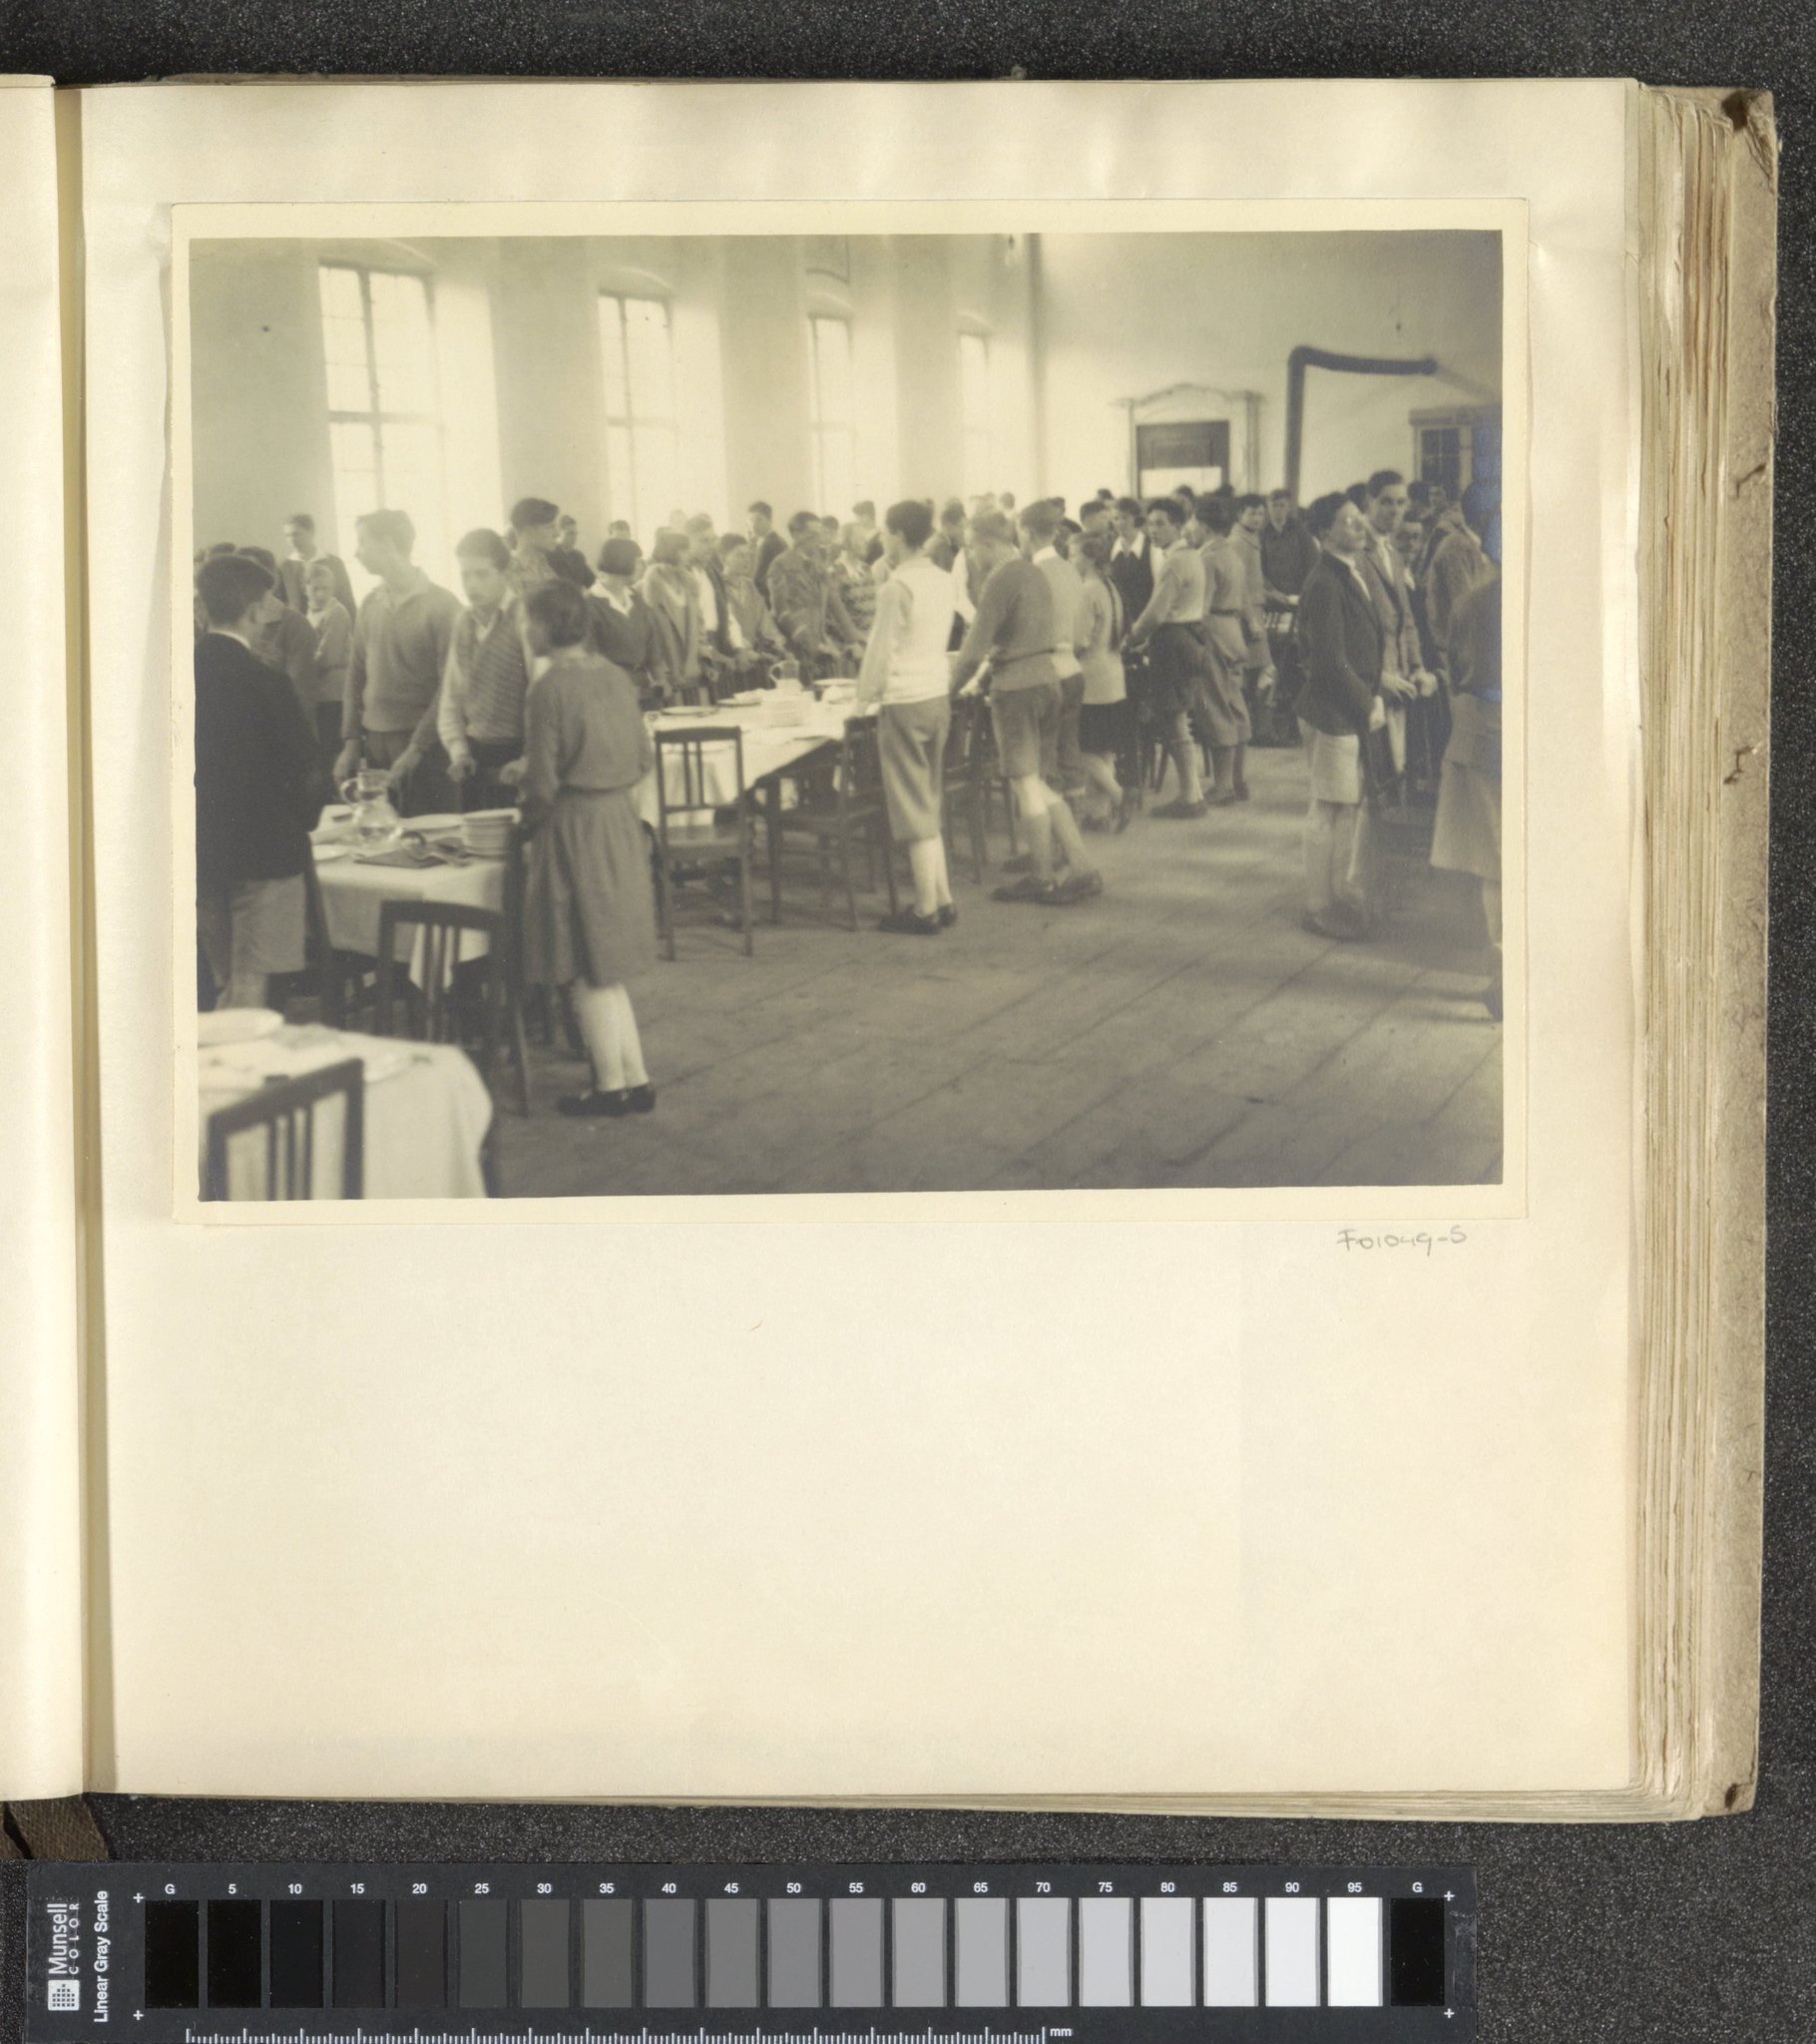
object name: photograph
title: Leerlingen van Schule Schloss Salem tijdens moment stilte voor de maaltijd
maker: Anonymous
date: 1929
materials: photographic support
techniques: gelatin silver print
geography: salem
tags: education, (family) meal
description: Onderdeel van Fotoalbum van Schule Schloss Salem.